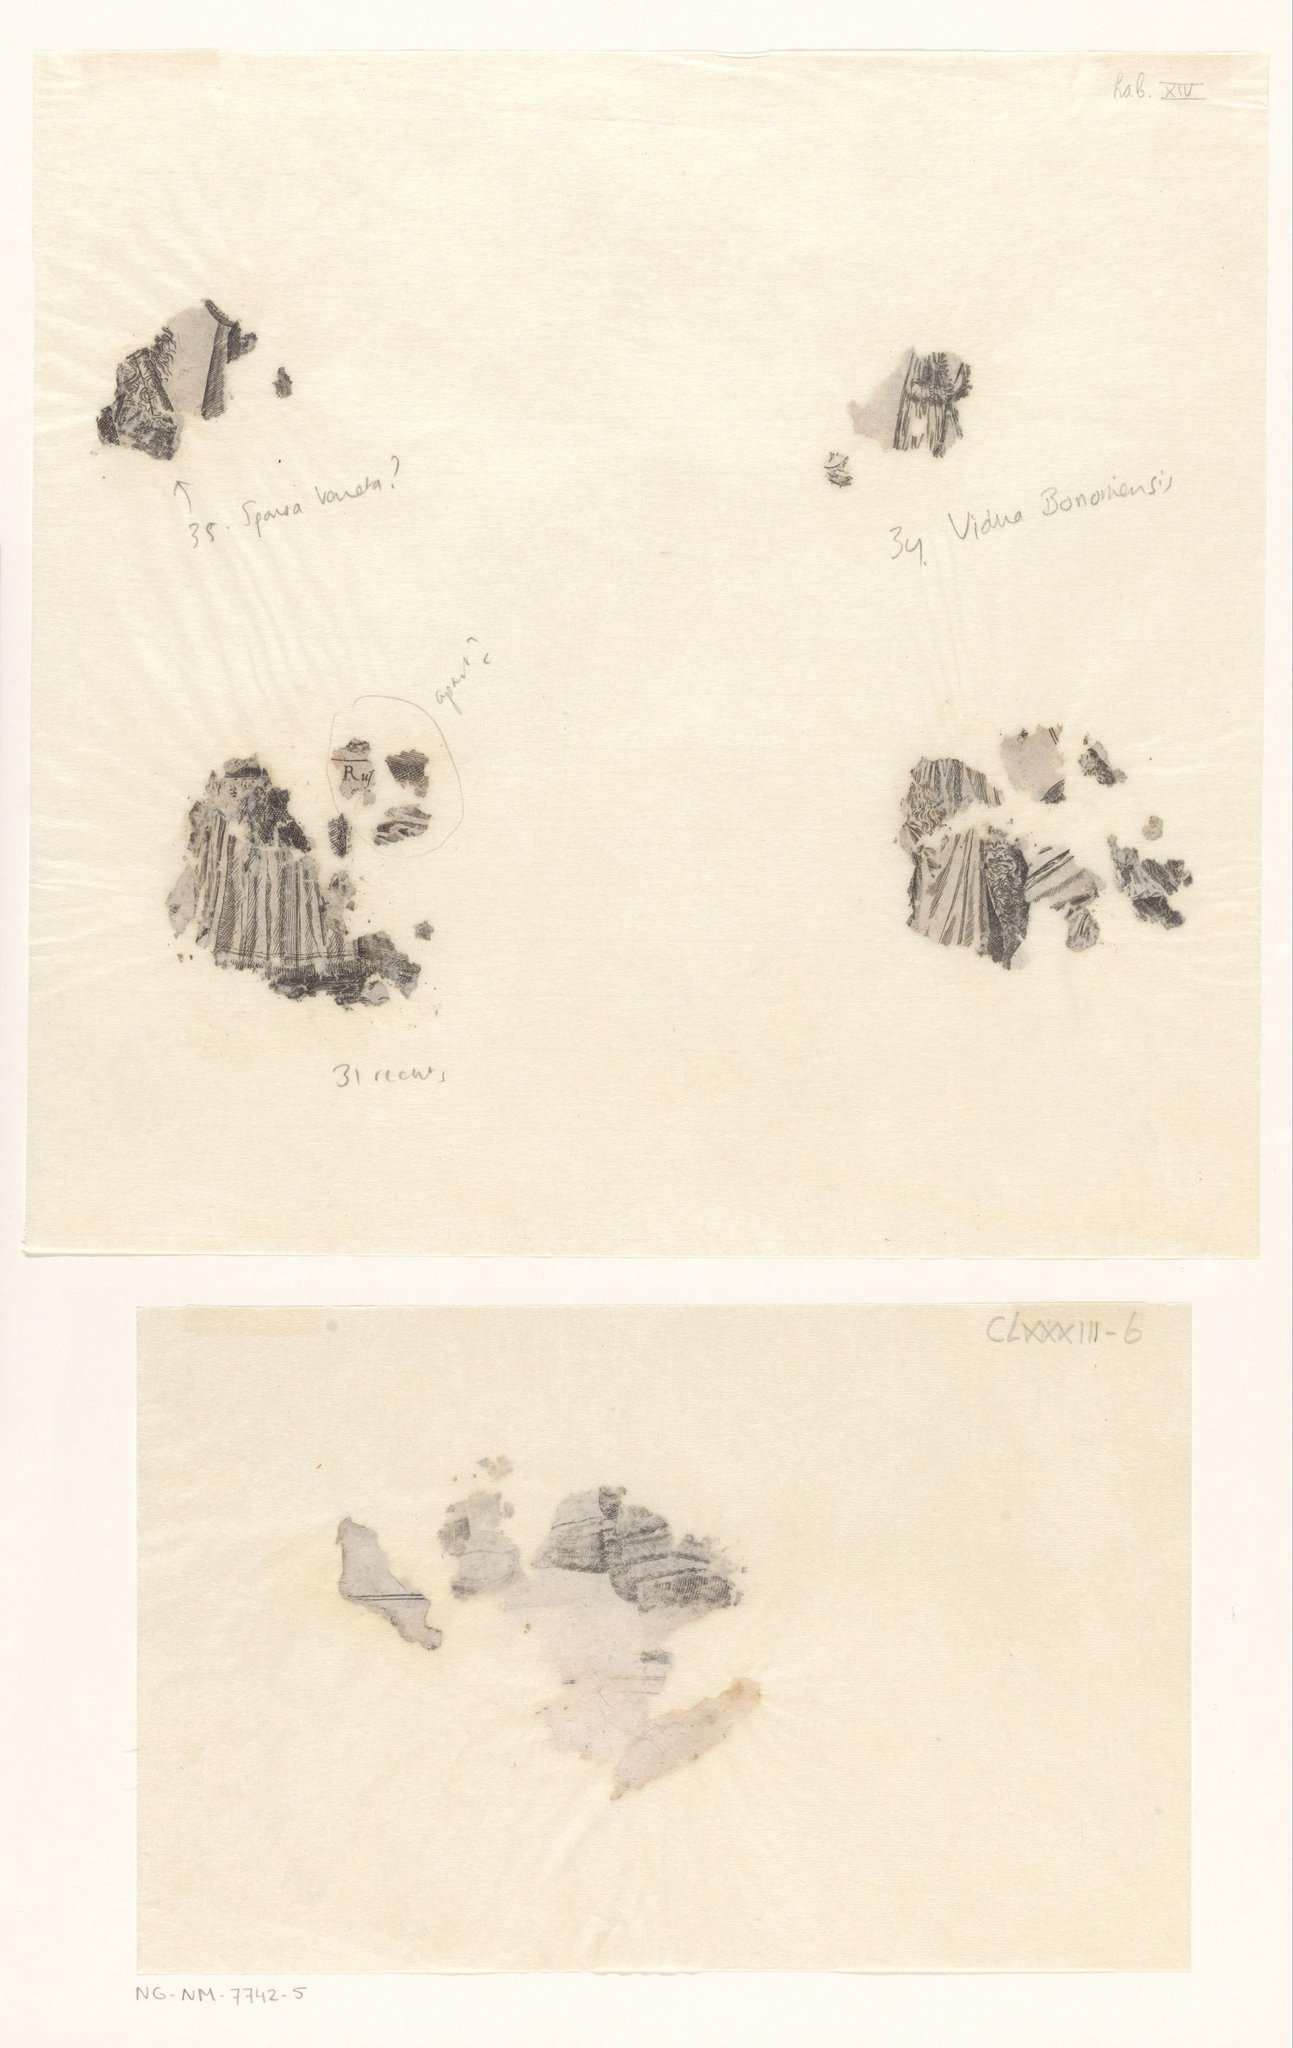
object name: costume print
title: Omnium pene Europae, Asiae, Aphricae atque Americae gentium habitus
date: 1581-1596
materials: paper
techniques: engraving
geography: cologne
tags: clothes, costume (+ women's clothes), clothes, costume (+ men's clothes)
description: De prenten in de Nova Zembla collectie zijn tijdens een expeditie van Willem Barendsz en Jacob van Heemskerk in 1596-1597 noodgedwongen in het winterkamp, het ‘Behouden Huis’, op het eiland achtergelaten. De prenten waren in één of meerdere stapels als handelswaar meegenomen vanuit Amsterdam. Bijna drie eeuwen later, in 1871, keerde de Noor Elling Carlsen terug naar Nova Zembla en vond daar de restanten van het ‘Behouden Huis, inclusief een groot deel van de inventaris. Een deel van de prenten, in de vorm van aaneengekoekte kluiten, werd toen ook teruggevonden. De papierkluiten waren soms op meerdere plekken gebroken. Tussen 1975-1979 zijn de prenten van elkaar gescheiden. Dit leverde in totaal ca. 1000 fragmenten van ca. 400 afdrukken van ca. 150 verschillende prenten op. Voor zover mogelijk zijn de fragmenten samengevoegd en zijn de prenten gereconstrueerd.